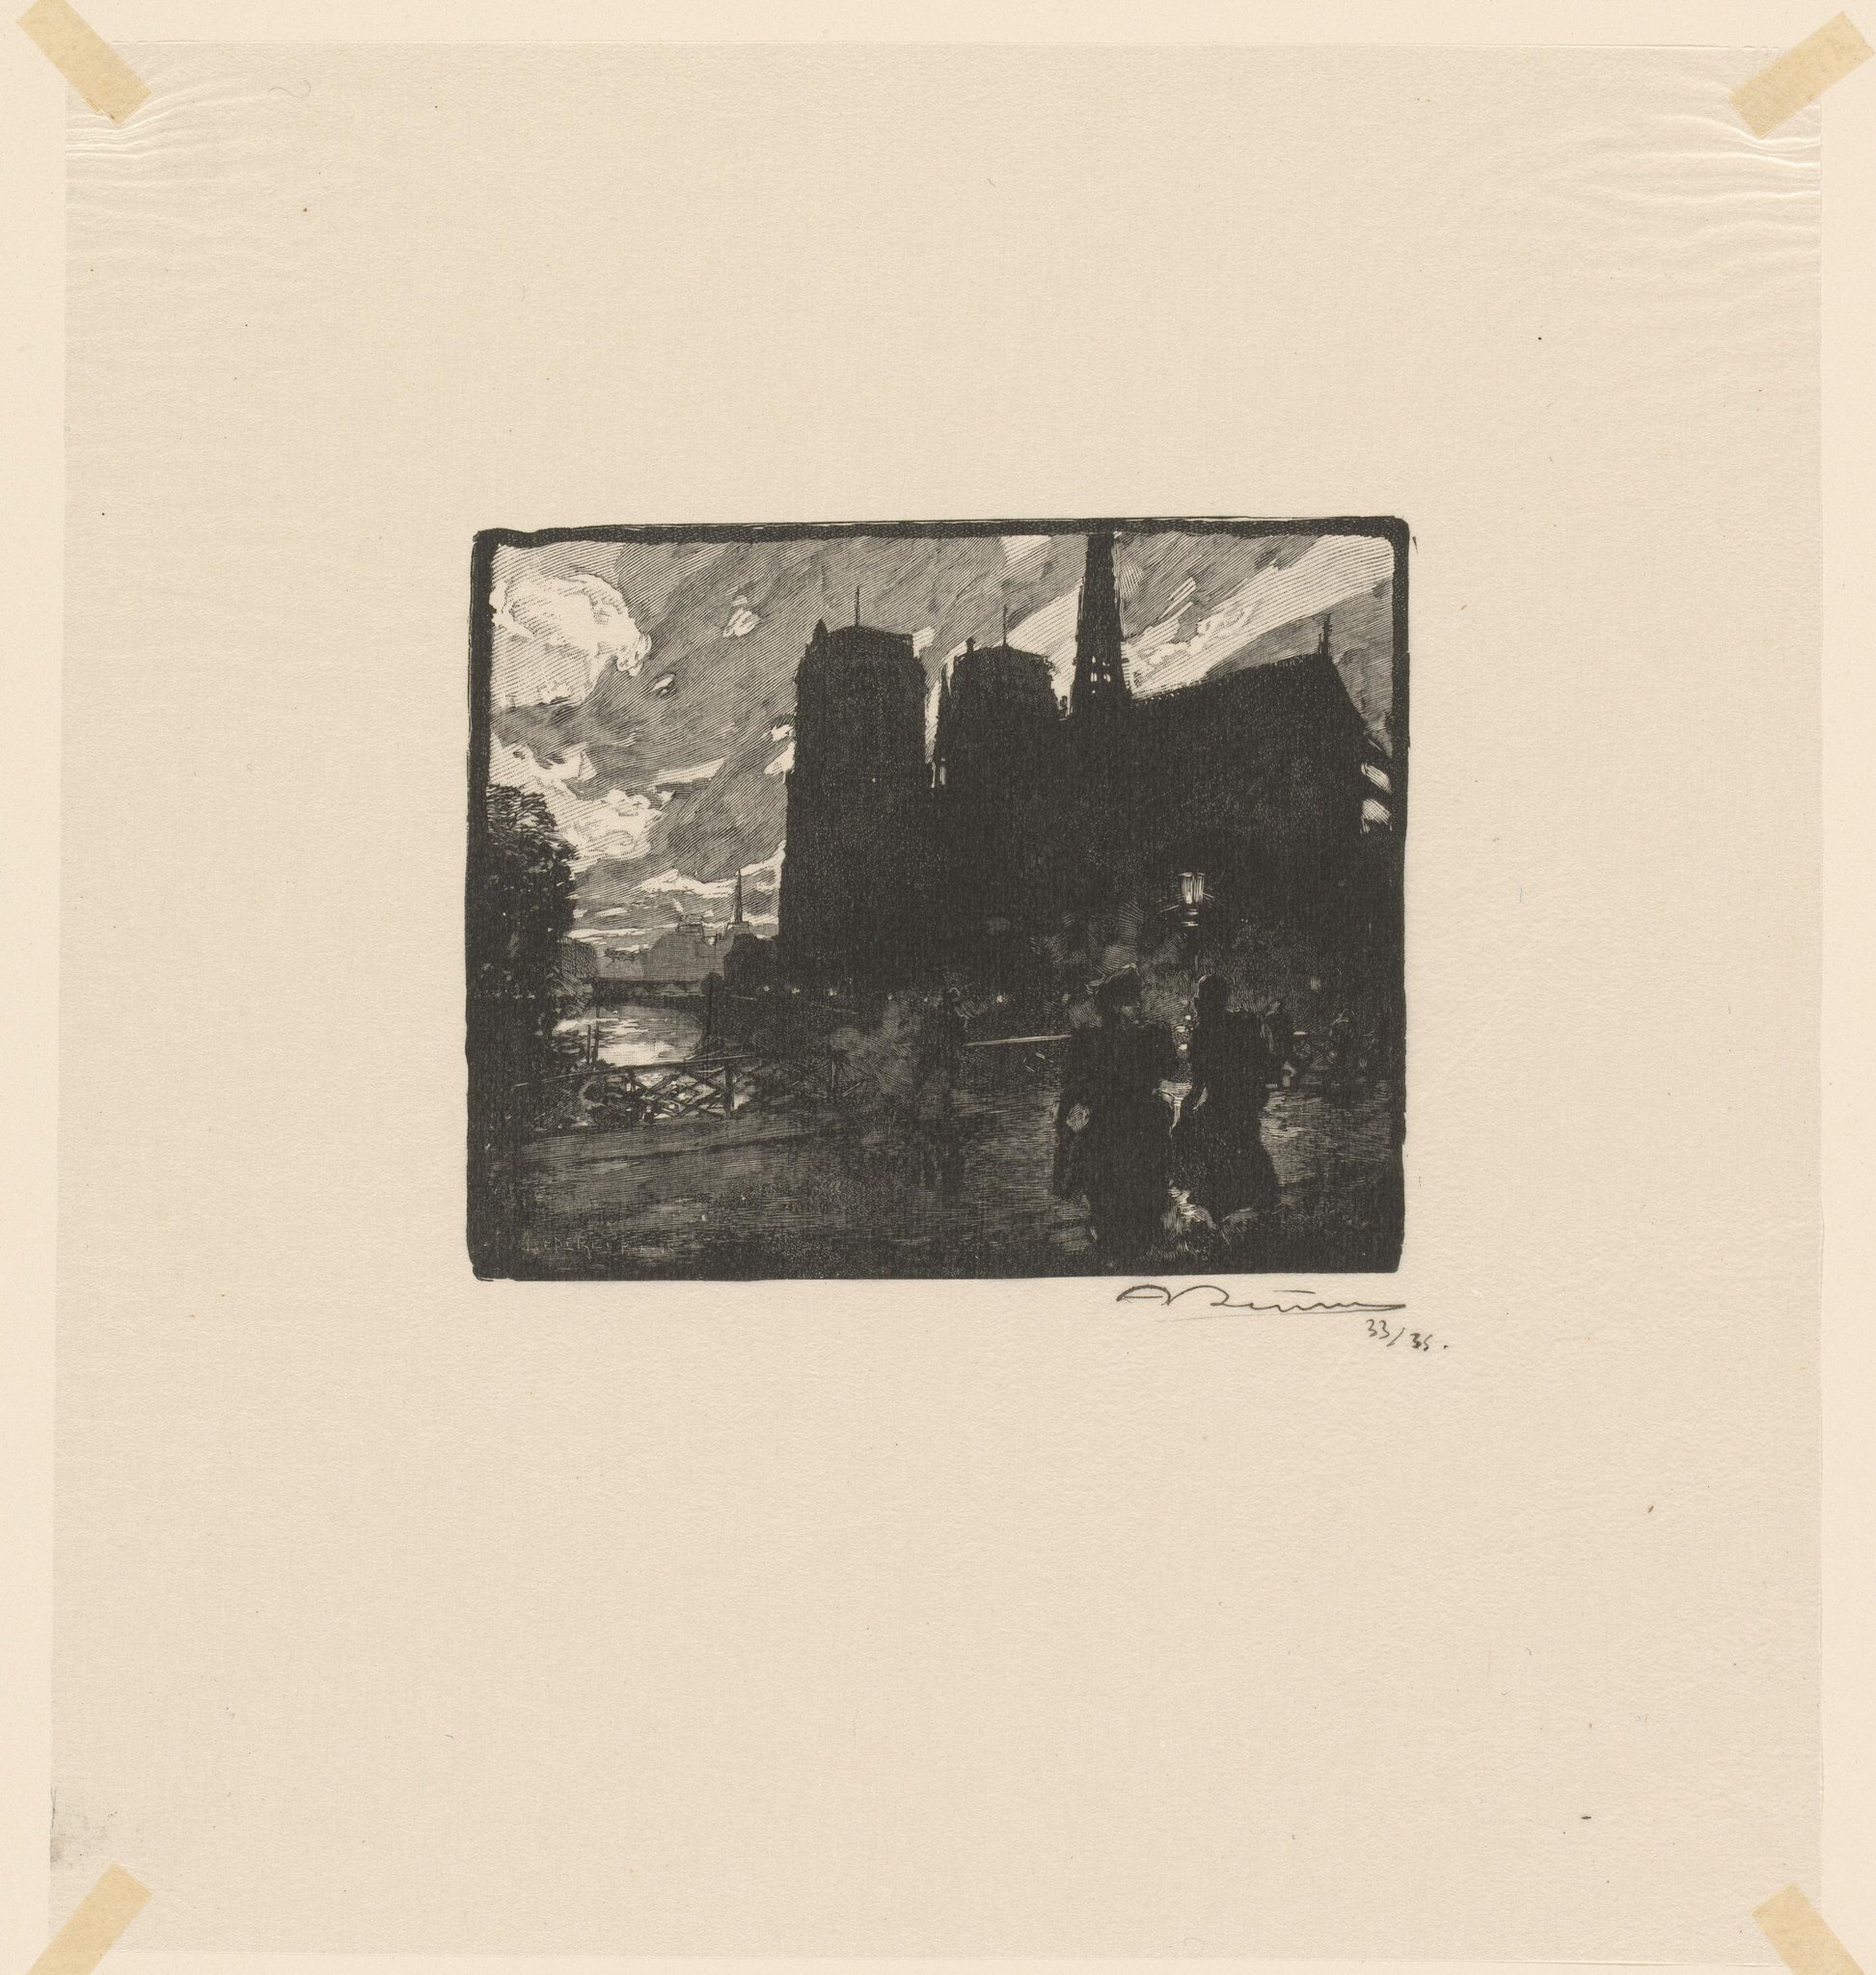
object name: print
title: Le long de la Seine et des boulevards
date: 1910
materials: paper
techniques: engraving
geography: paris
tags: church (exterior)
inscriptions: collector's mark: Lugt 2228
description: Deze serie heeft als titel 'Le long de la Seine et des boulevards'. Deze serie is het vierde deel van het grotere geheel 'L'Oeuvre gravé sur bois de Auguste Lepère'.